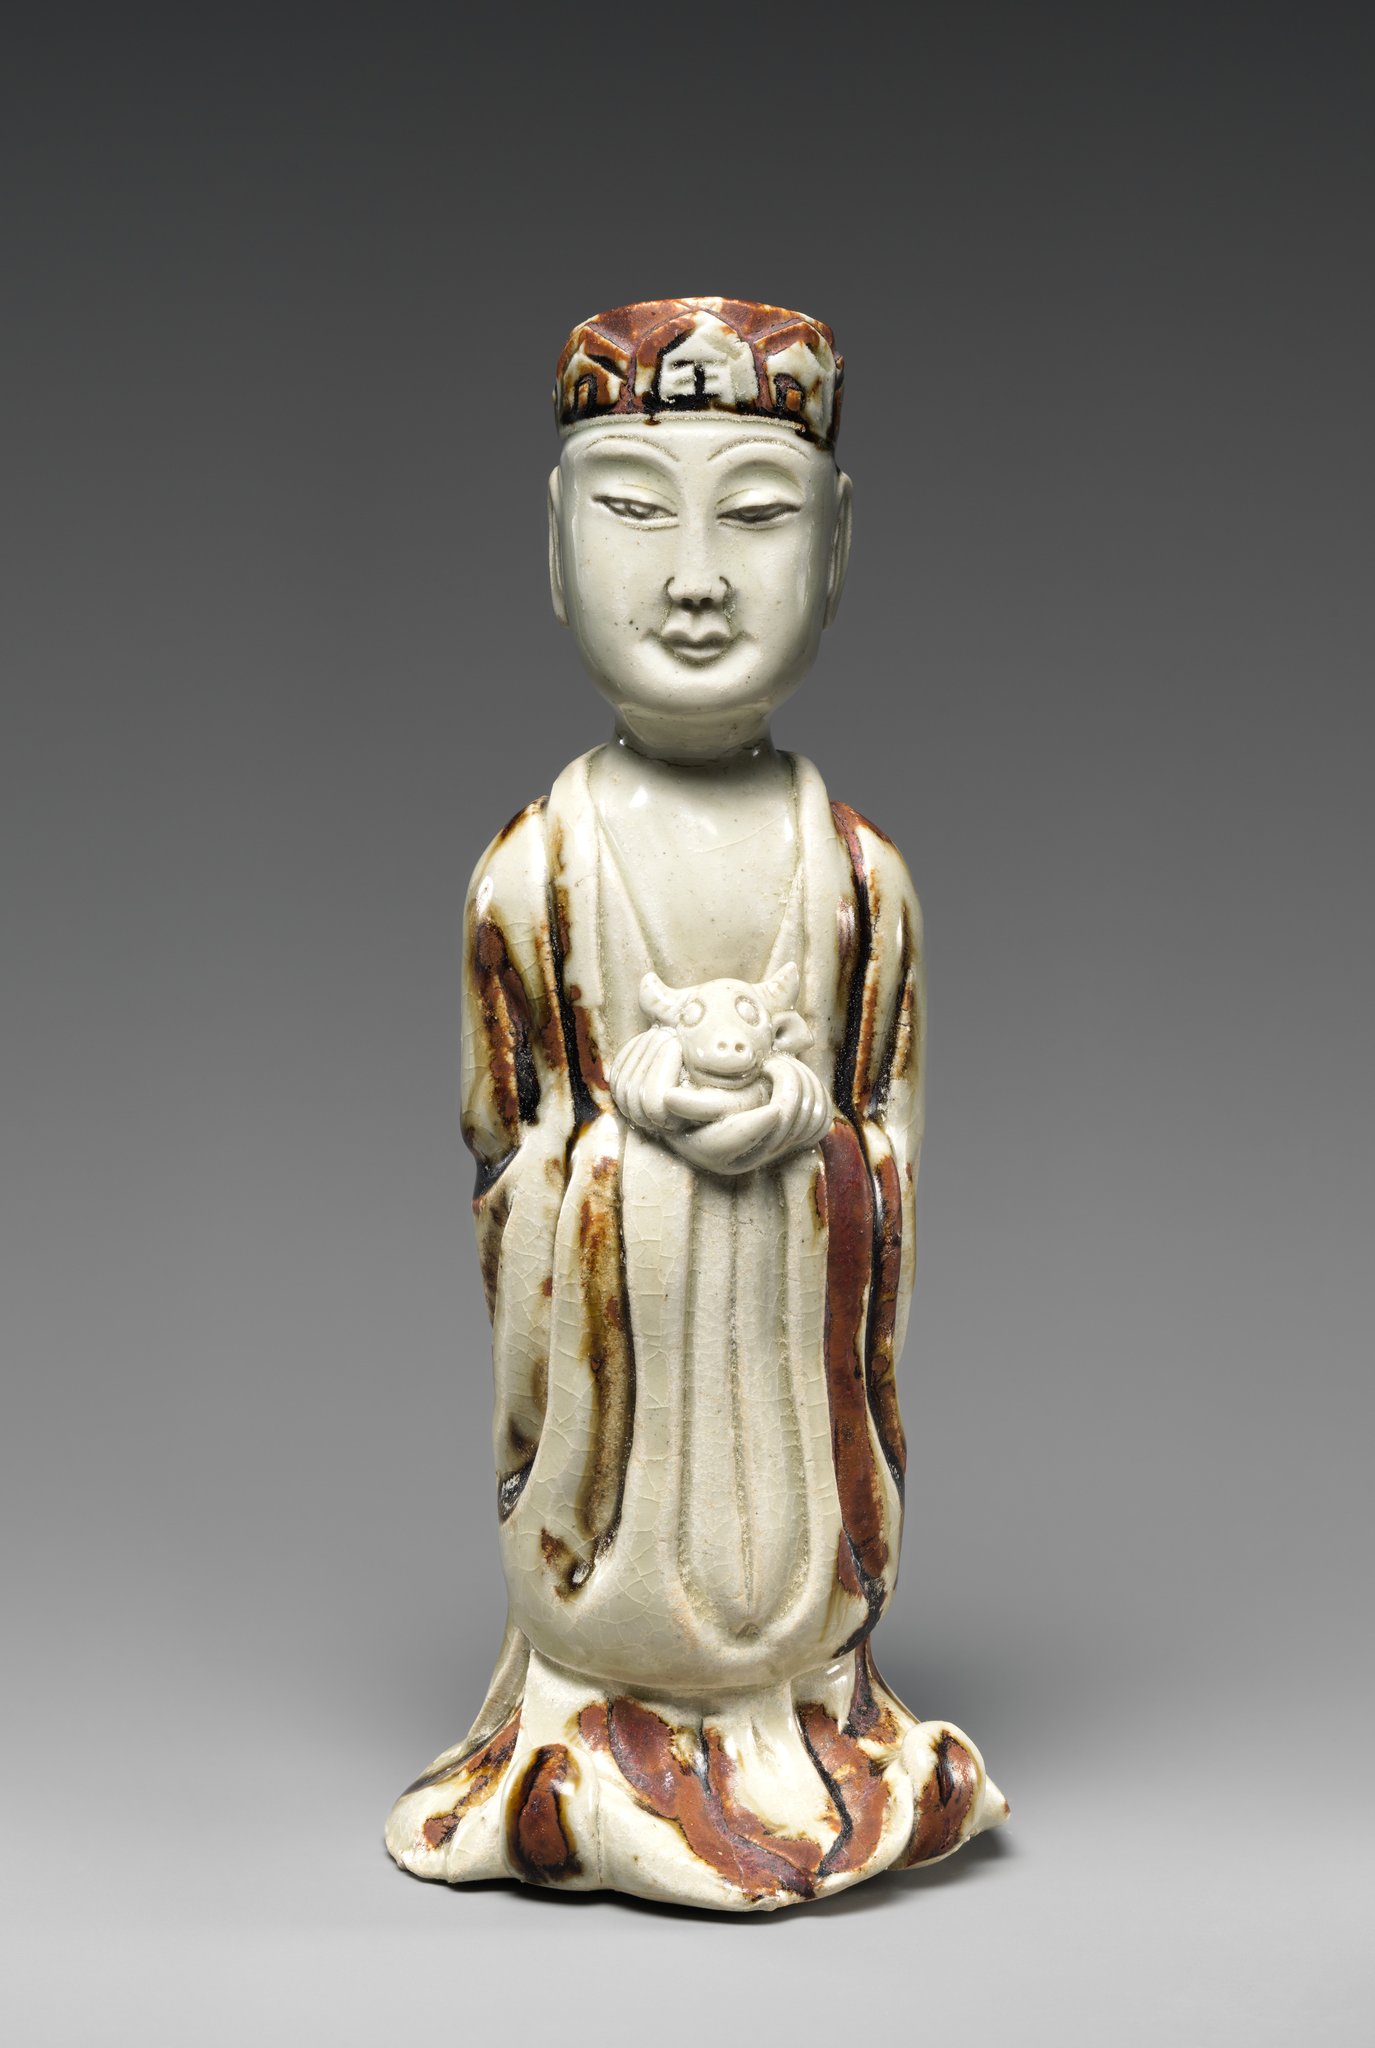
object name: figure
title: Zodiac Figure of an Ox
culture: chinese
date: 1271-1368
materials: stoneware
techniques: glazing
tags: men,ox